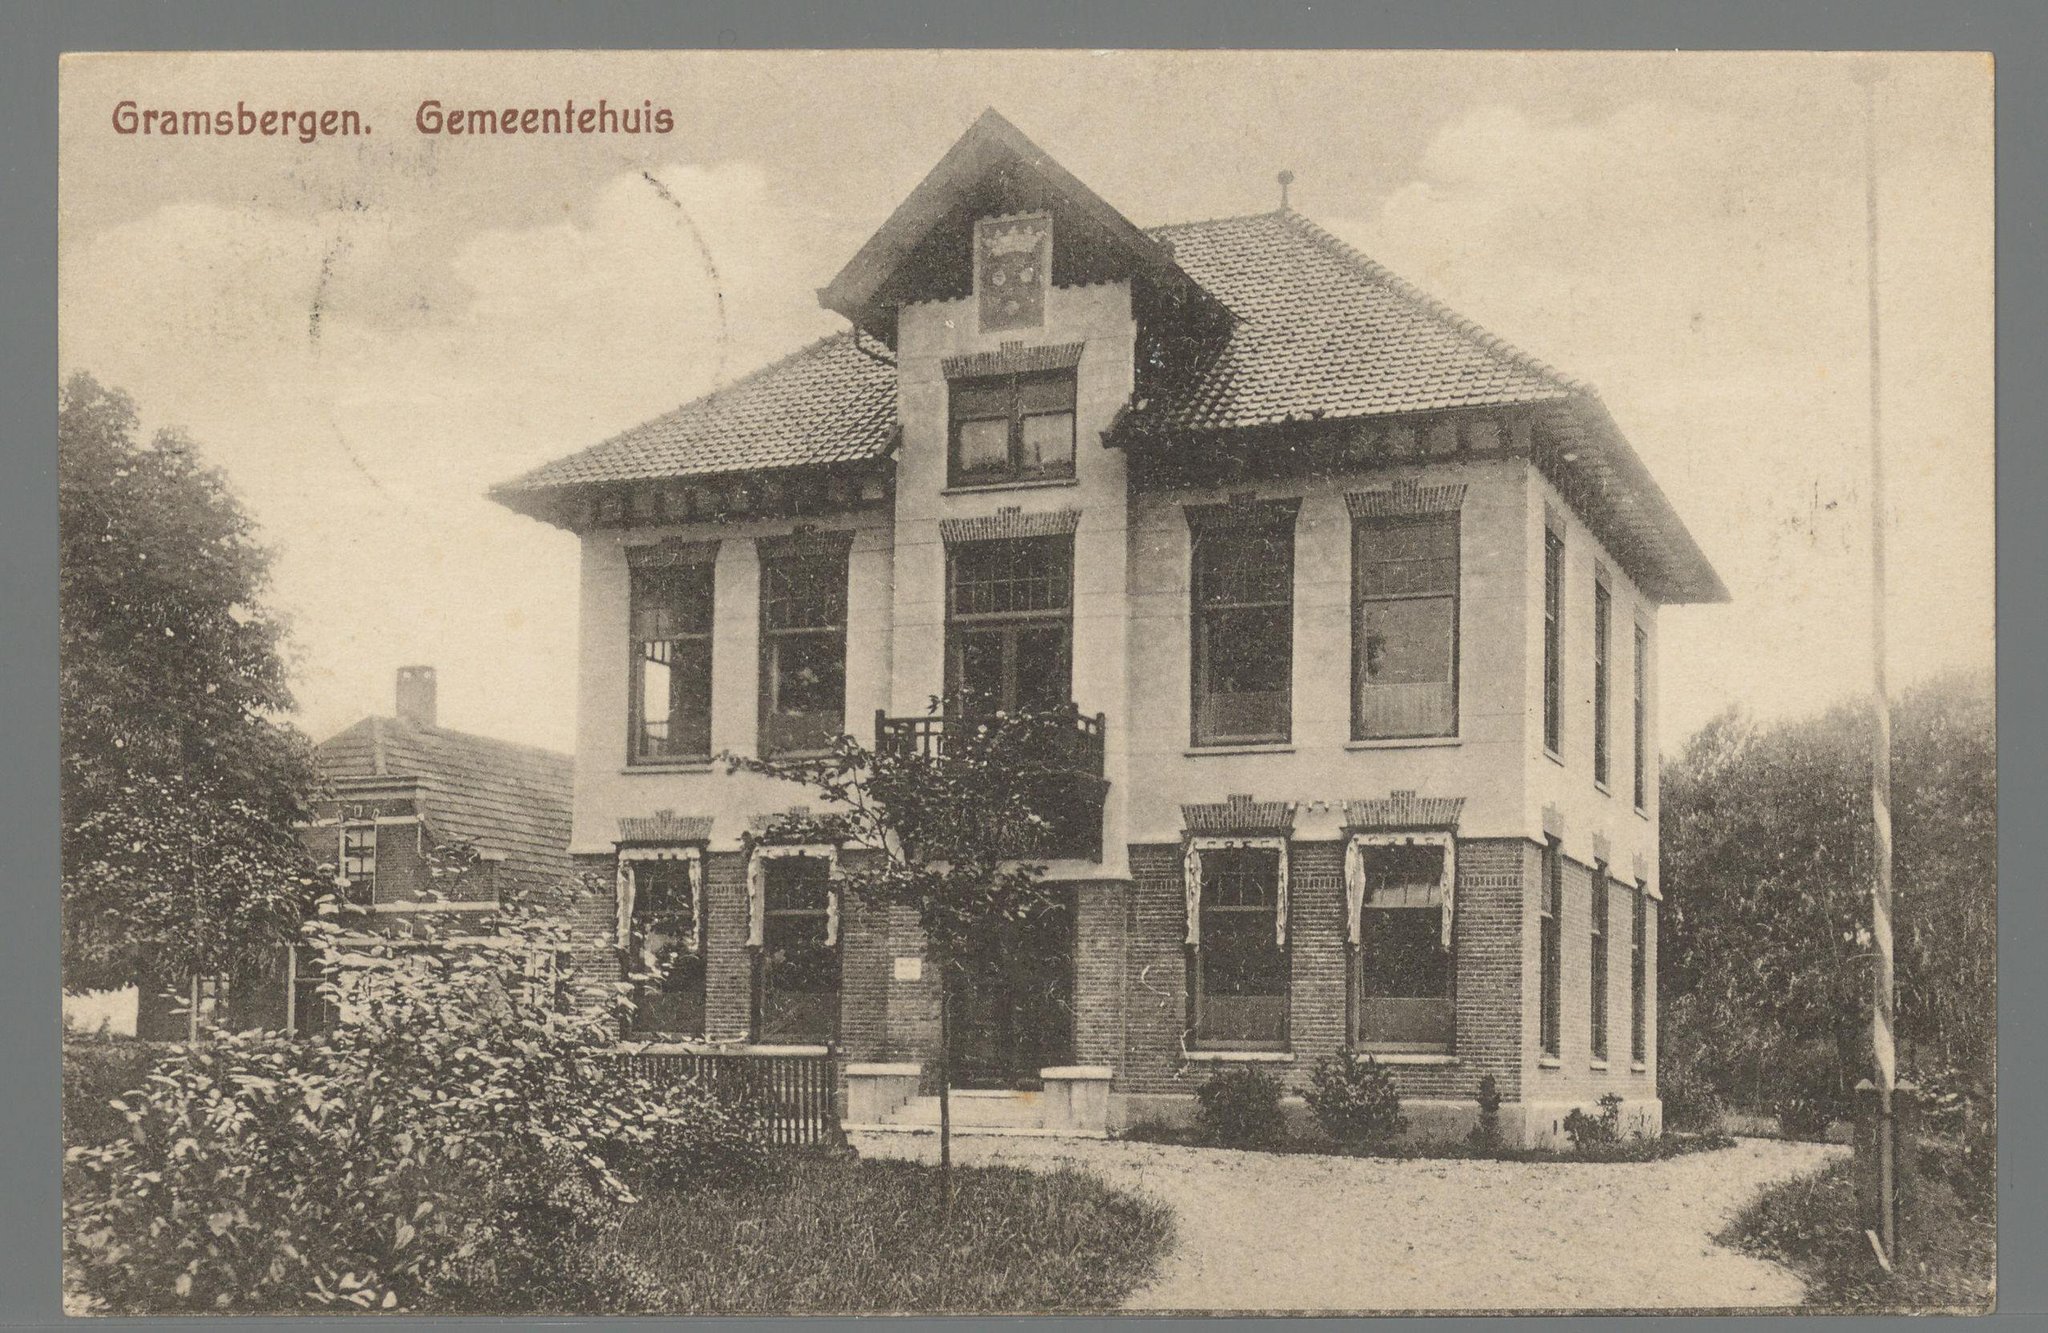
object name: ansichtkaart, prentbriefkaart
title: Gramsbergen. Gemeentehuis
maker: Anonymous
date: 1905-1927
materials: cardboard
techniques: photograph, writing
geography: gramsbergen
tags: townhall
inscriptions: postage stamp